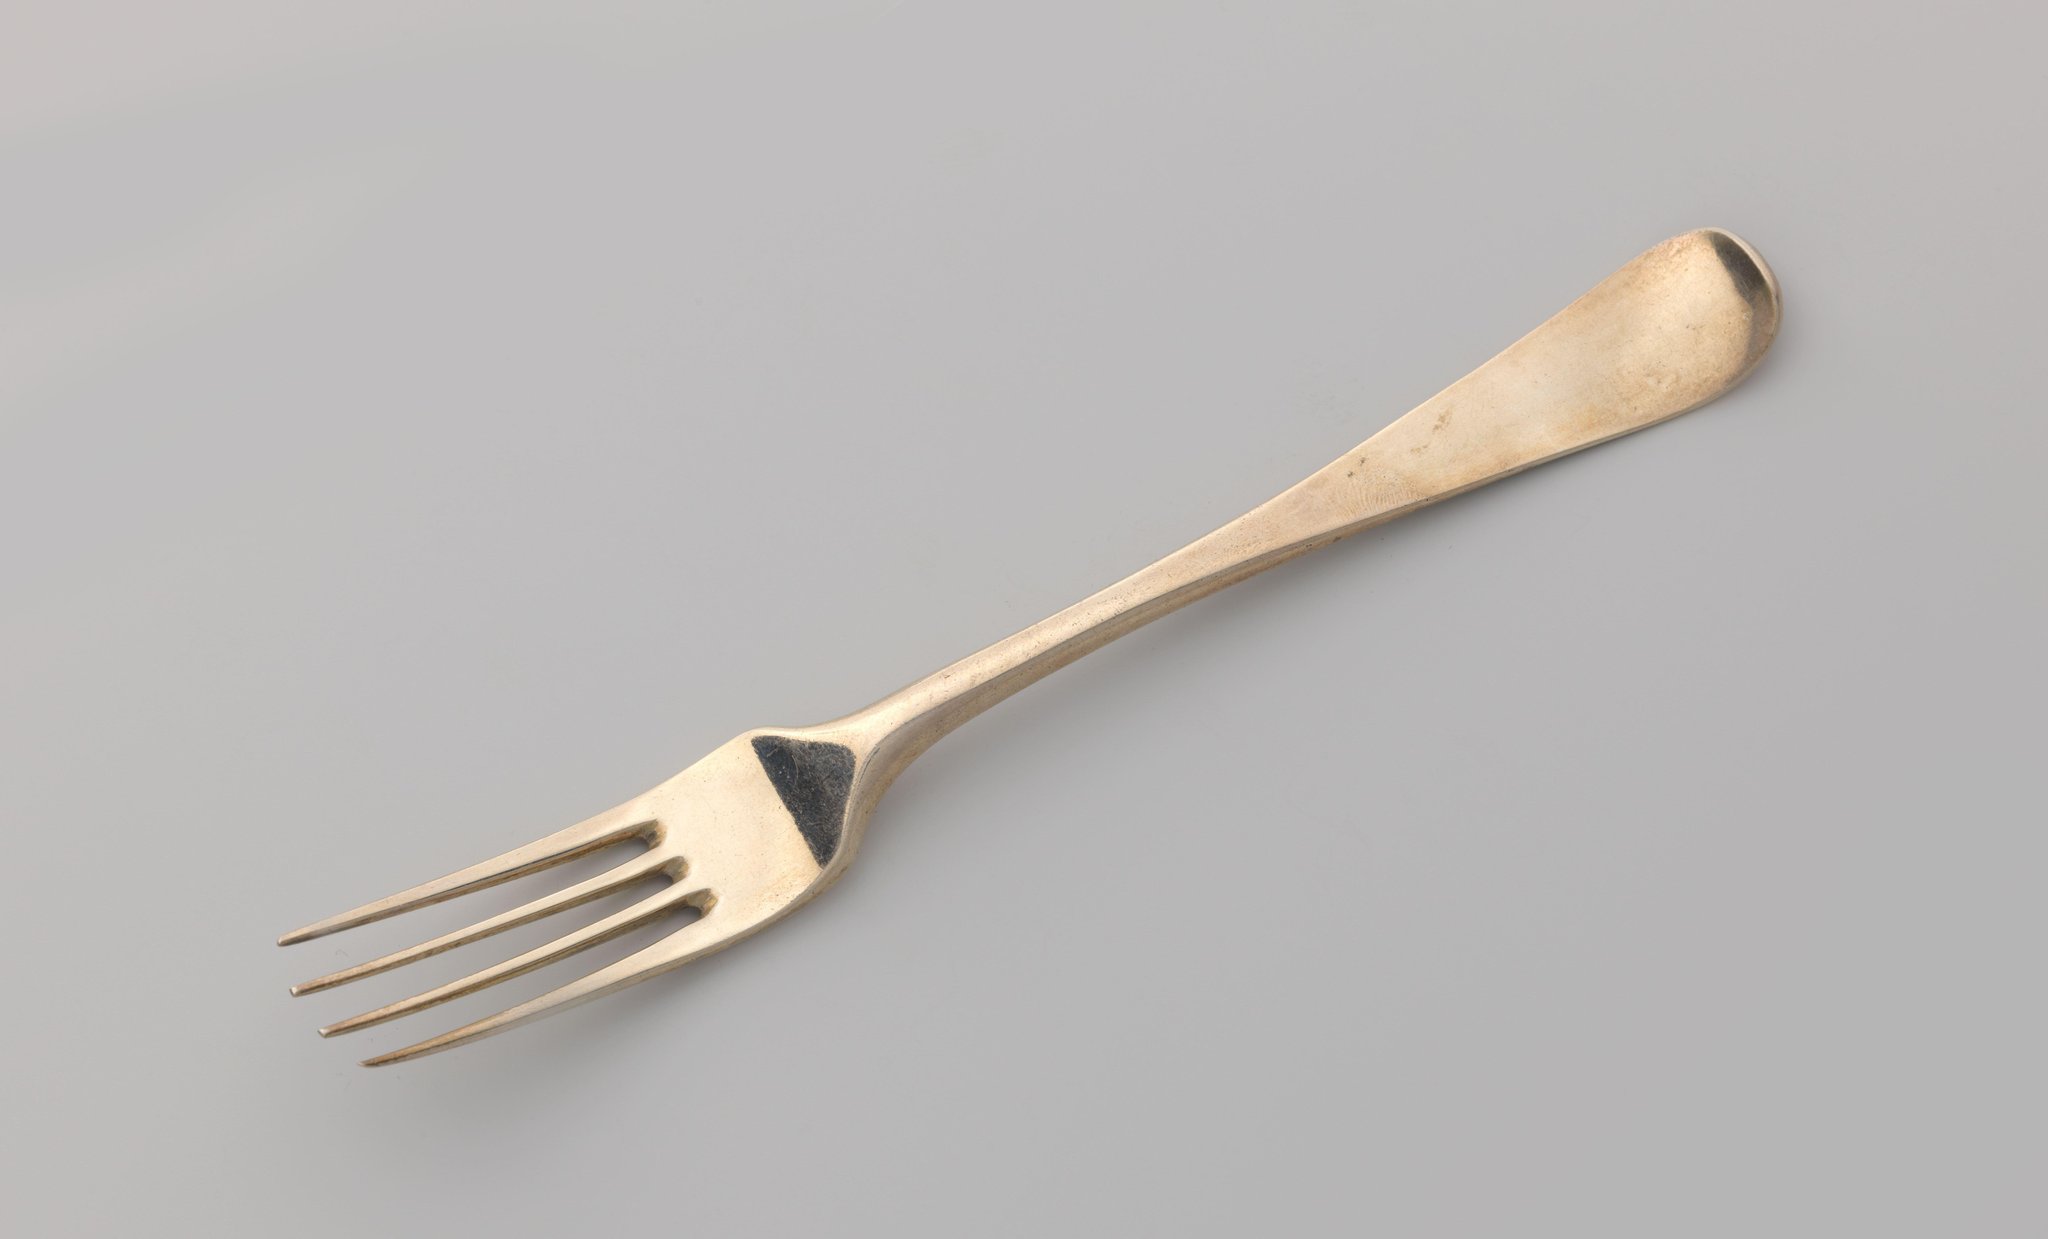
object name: fork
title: Vork met steel met opkrullend, afgerond uiteinde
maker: jacob van nieuwcasteel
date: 1791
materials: silver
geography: utrecht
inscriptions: date letter: ‘H’, town mark, maker's mark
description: Vork van zilver. De steel is recht en plat met een opkrullend, afgerond uiteinde.